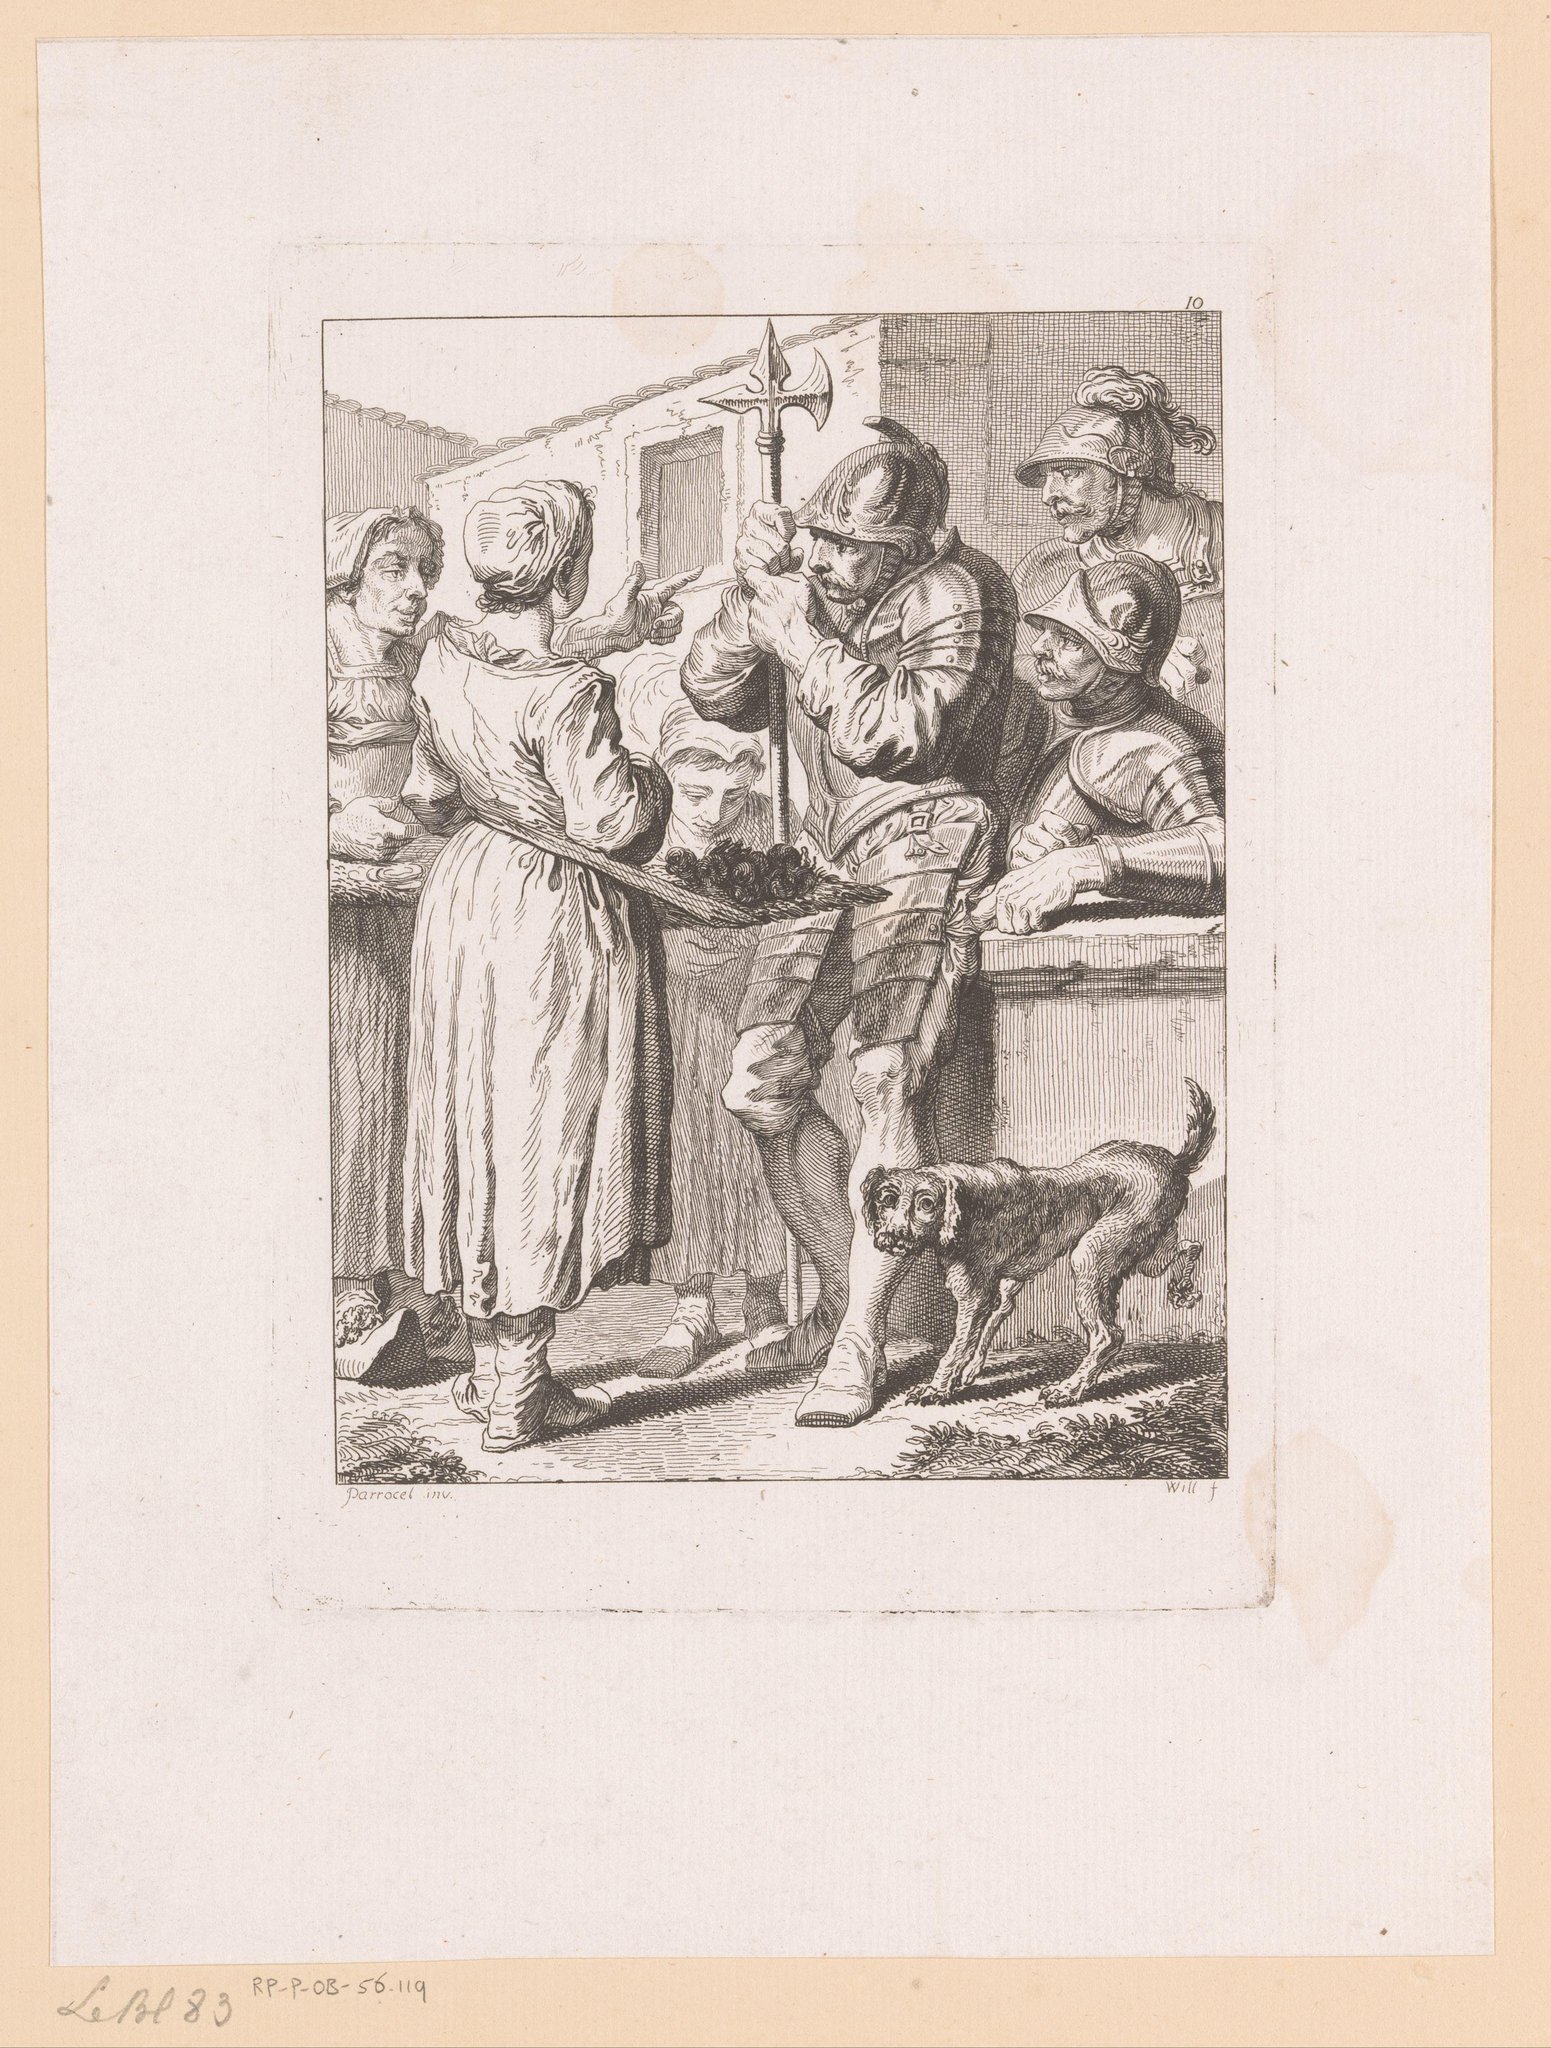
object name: print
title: Soldaten in gesprek met marktvrouwen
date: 1753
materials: paper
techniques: etching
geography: paris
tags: the soldier; the soldier's life, dog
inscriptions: collector's mark: Lugt 240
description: Deze prent maakt deel uit van een serie van ten minste twaalf prenten met voorstellingen van soldaten.